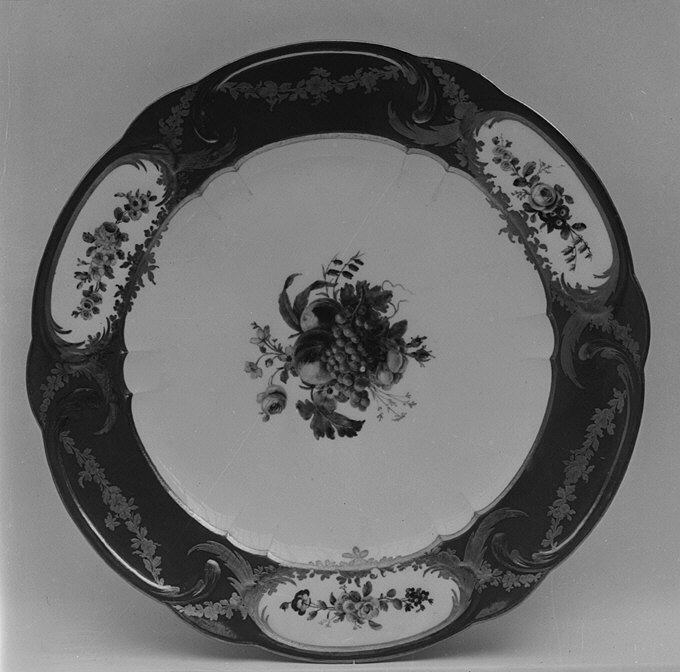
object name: plate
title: Plate (assiette à palmes) (1 of 102) (part of a service)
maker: sèvres manufactory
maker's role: manufactory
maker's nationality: french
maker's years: 1740-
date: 1780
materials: soft paste porcelain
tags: fruit,flowers